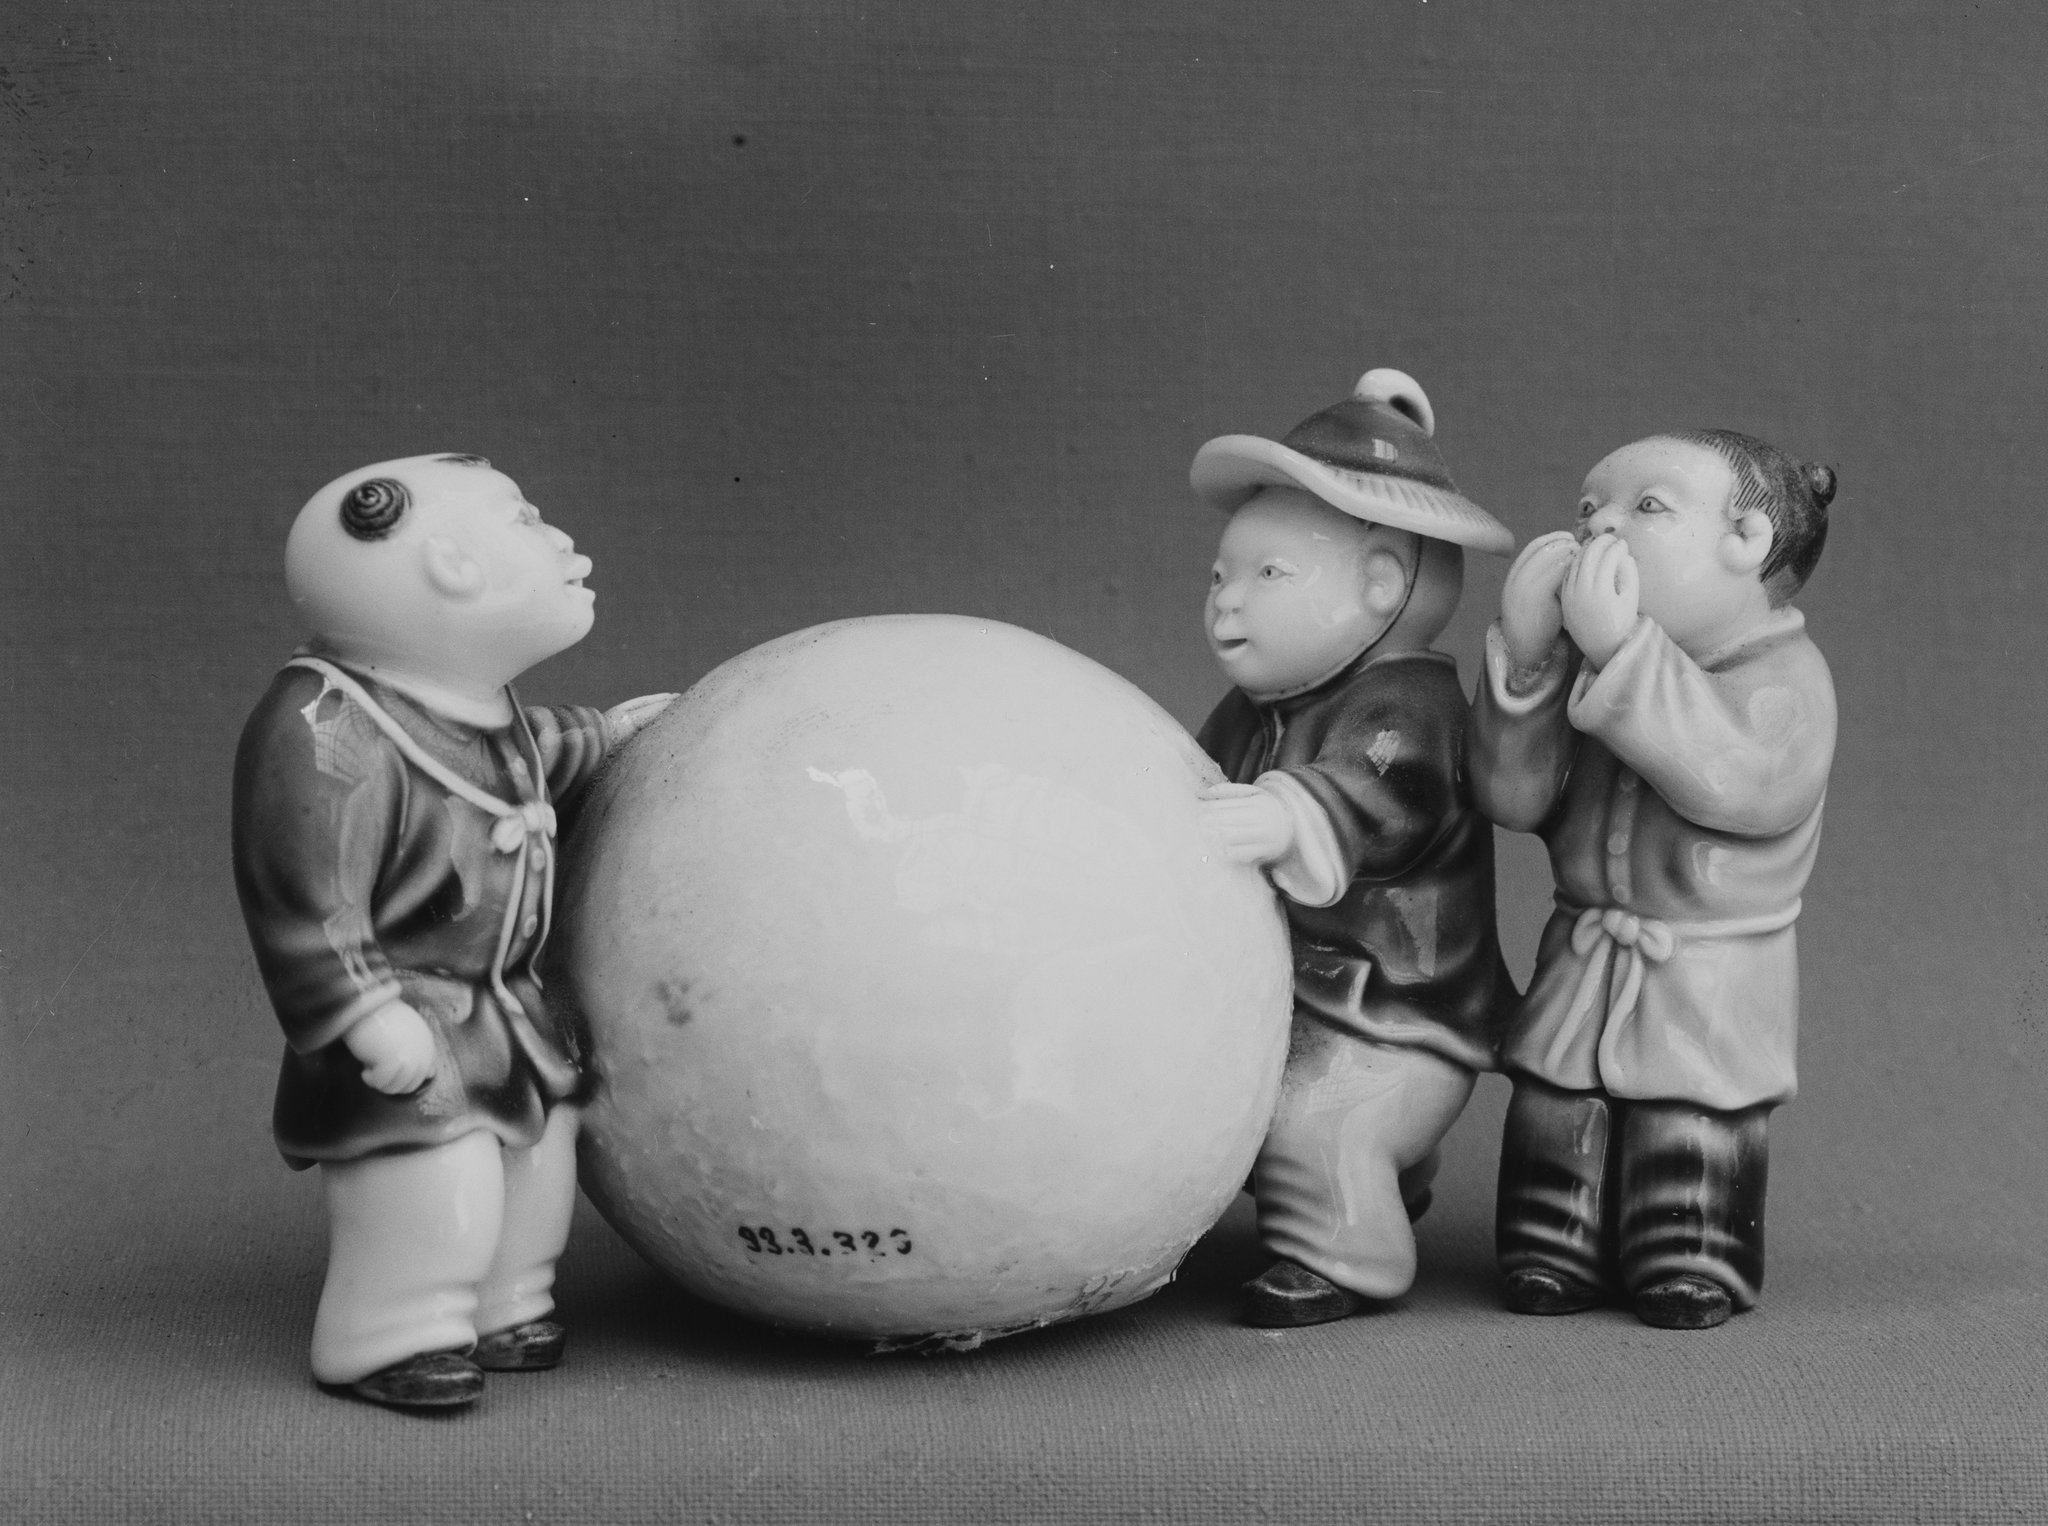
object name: ornament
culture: japanese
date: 1760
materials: enamel, glaze, porcelain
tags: human figures